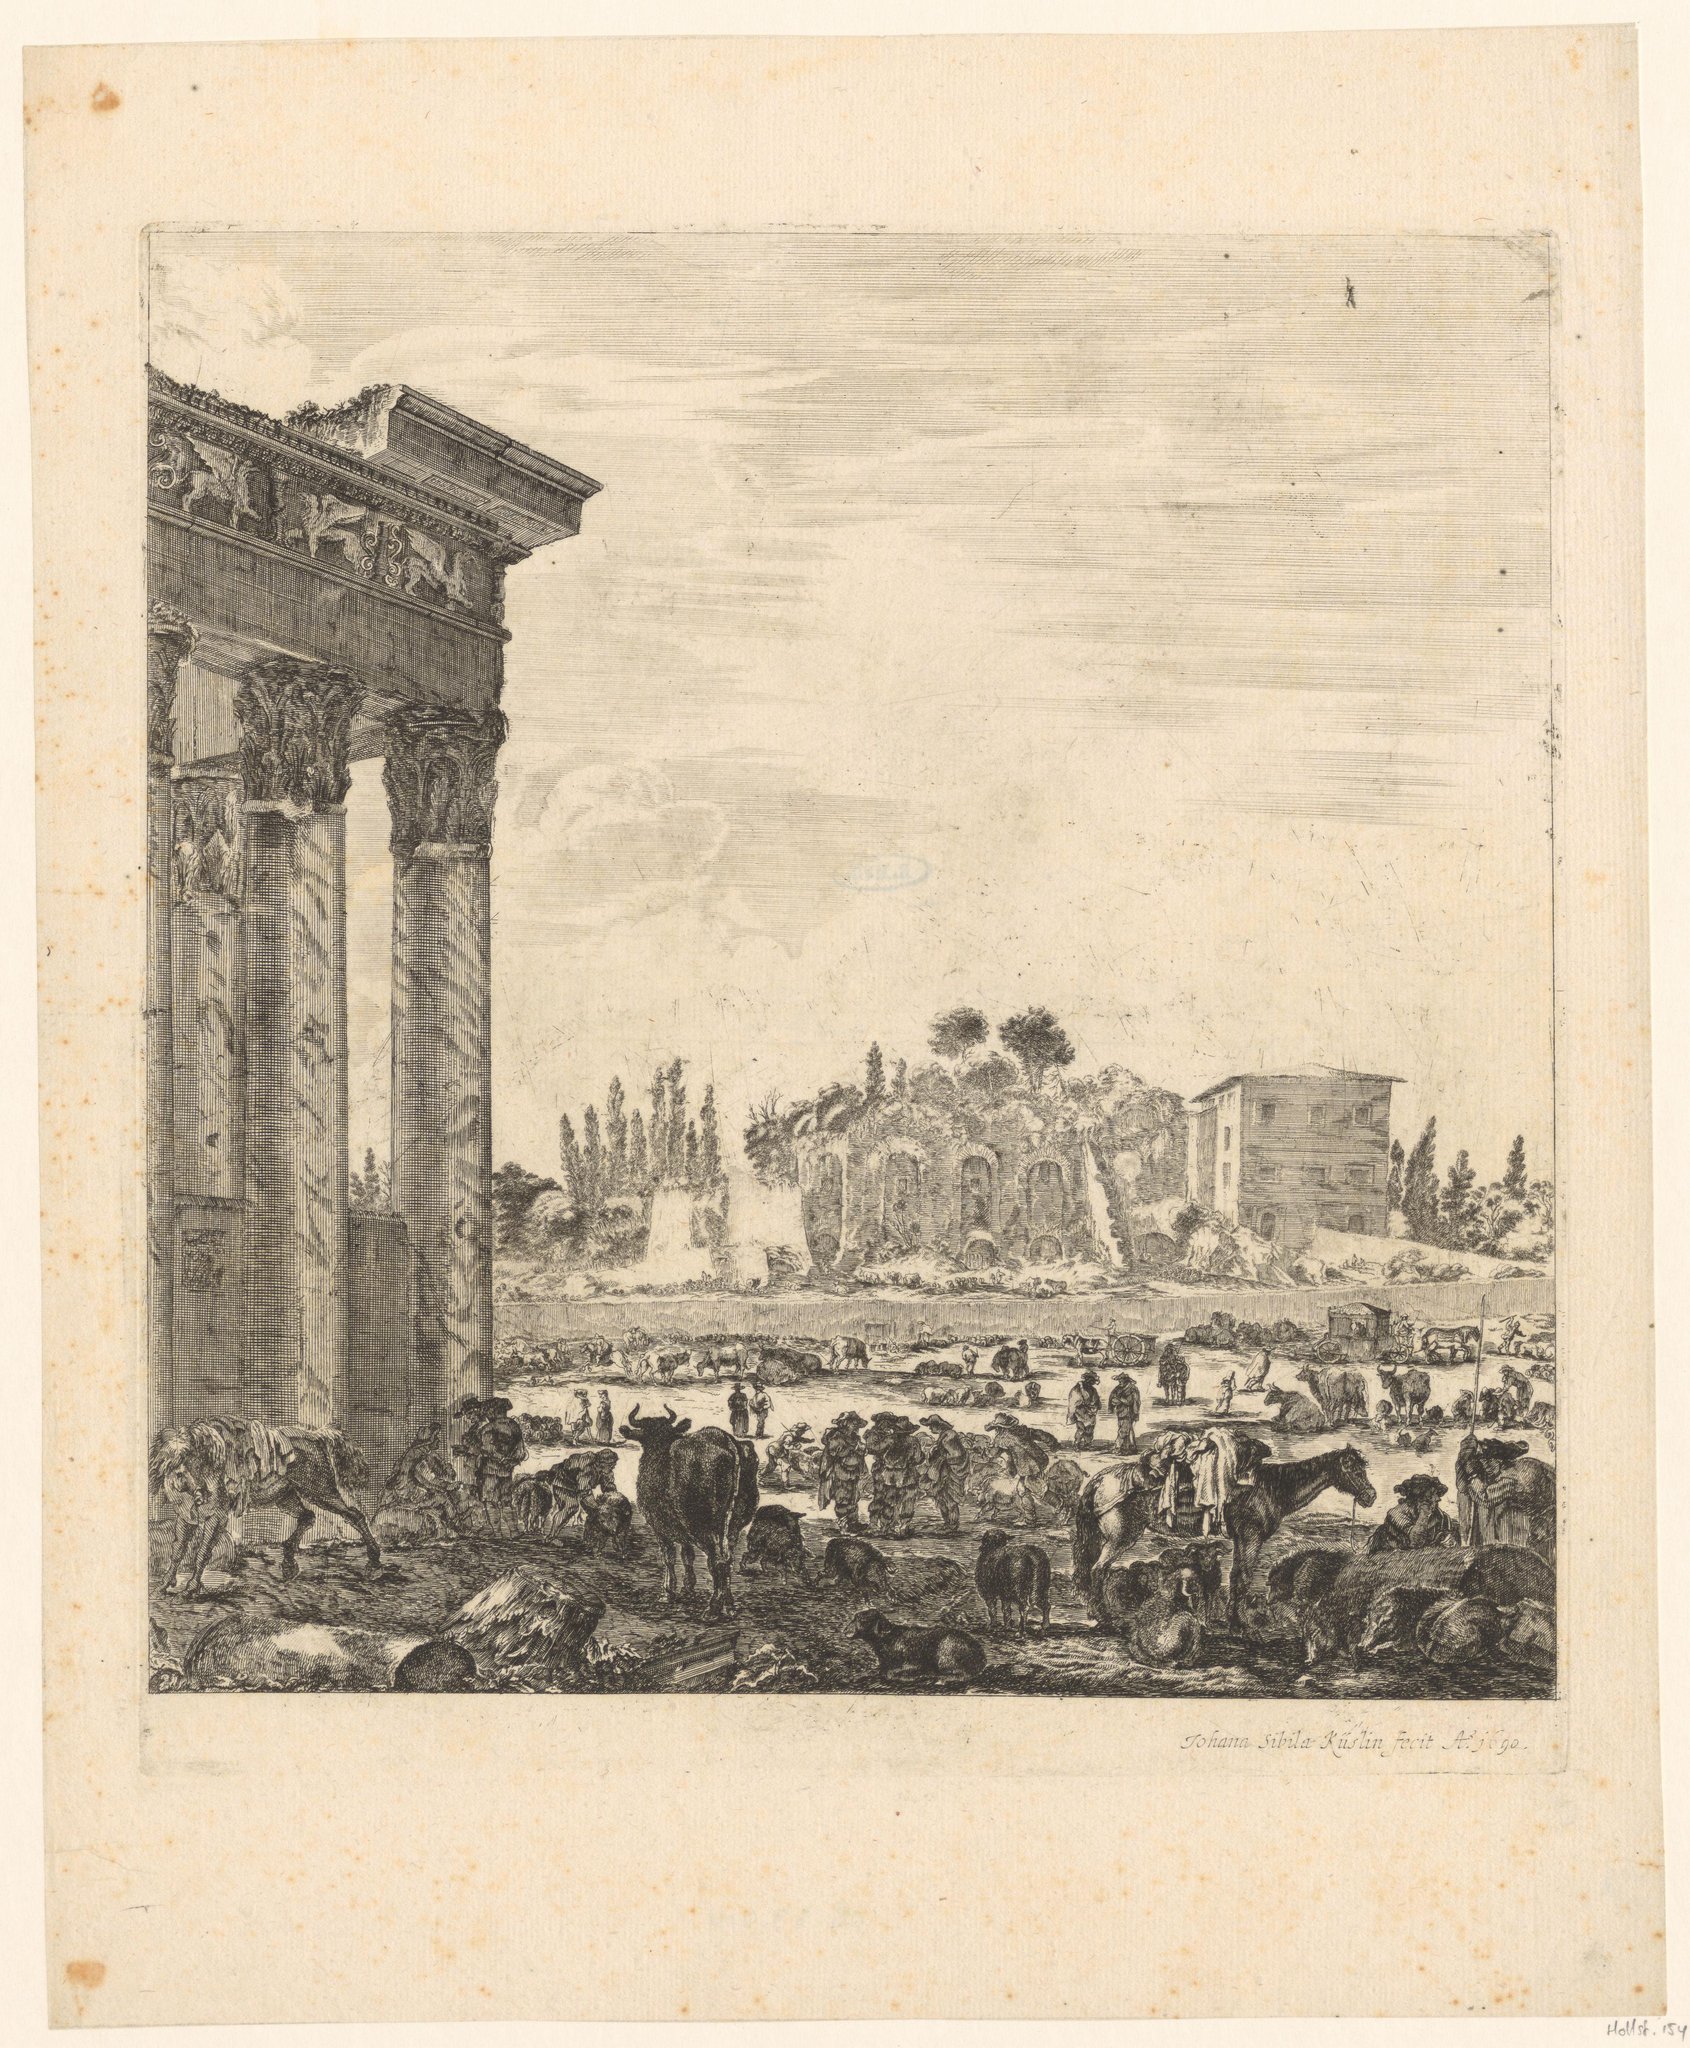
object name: print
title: Gezichten op Rome en Tivoli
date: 1690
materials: paper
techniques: etching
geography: augsburg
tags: cattle, landscape with ruins (+ city(-scape) with figures, staffage)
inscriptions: collector's mark: Lugt 240, collector's mark: Lugt 2228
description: Deze prent hoort bij een serie met twaalf prenten.